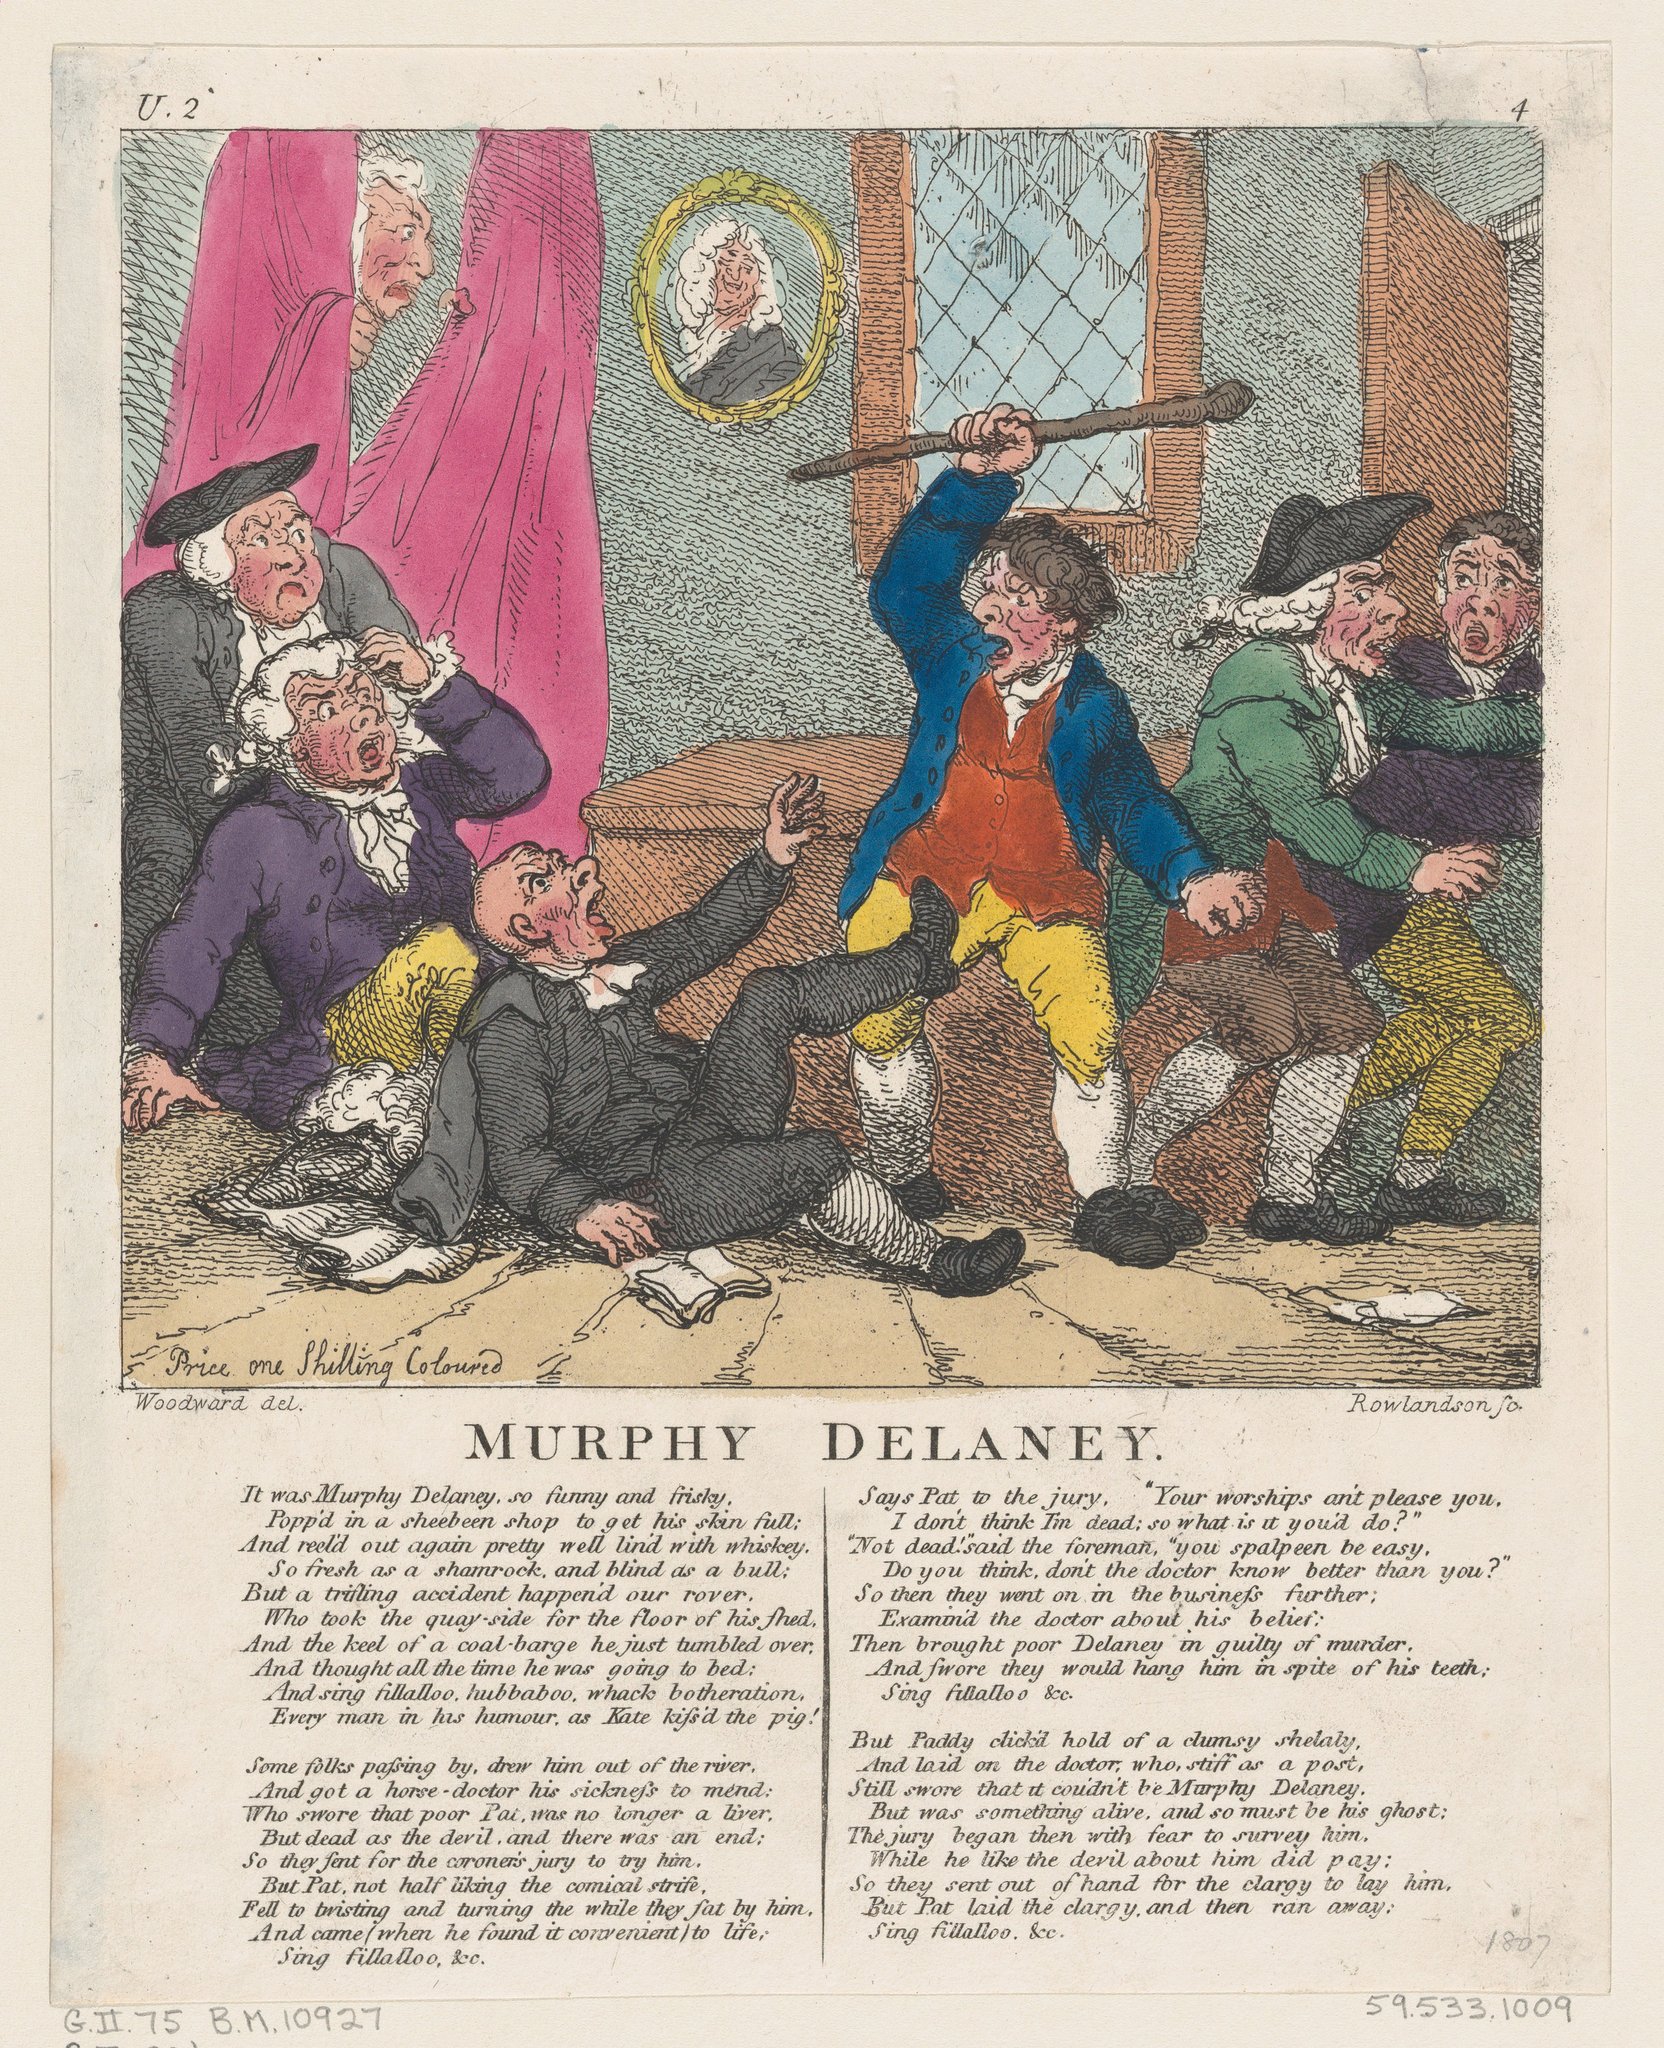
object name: print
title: Murphy Delaney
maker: thomas rowlandson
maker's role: artist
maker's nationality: british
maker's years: 1757-1827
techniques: etching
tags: satire,anger,men